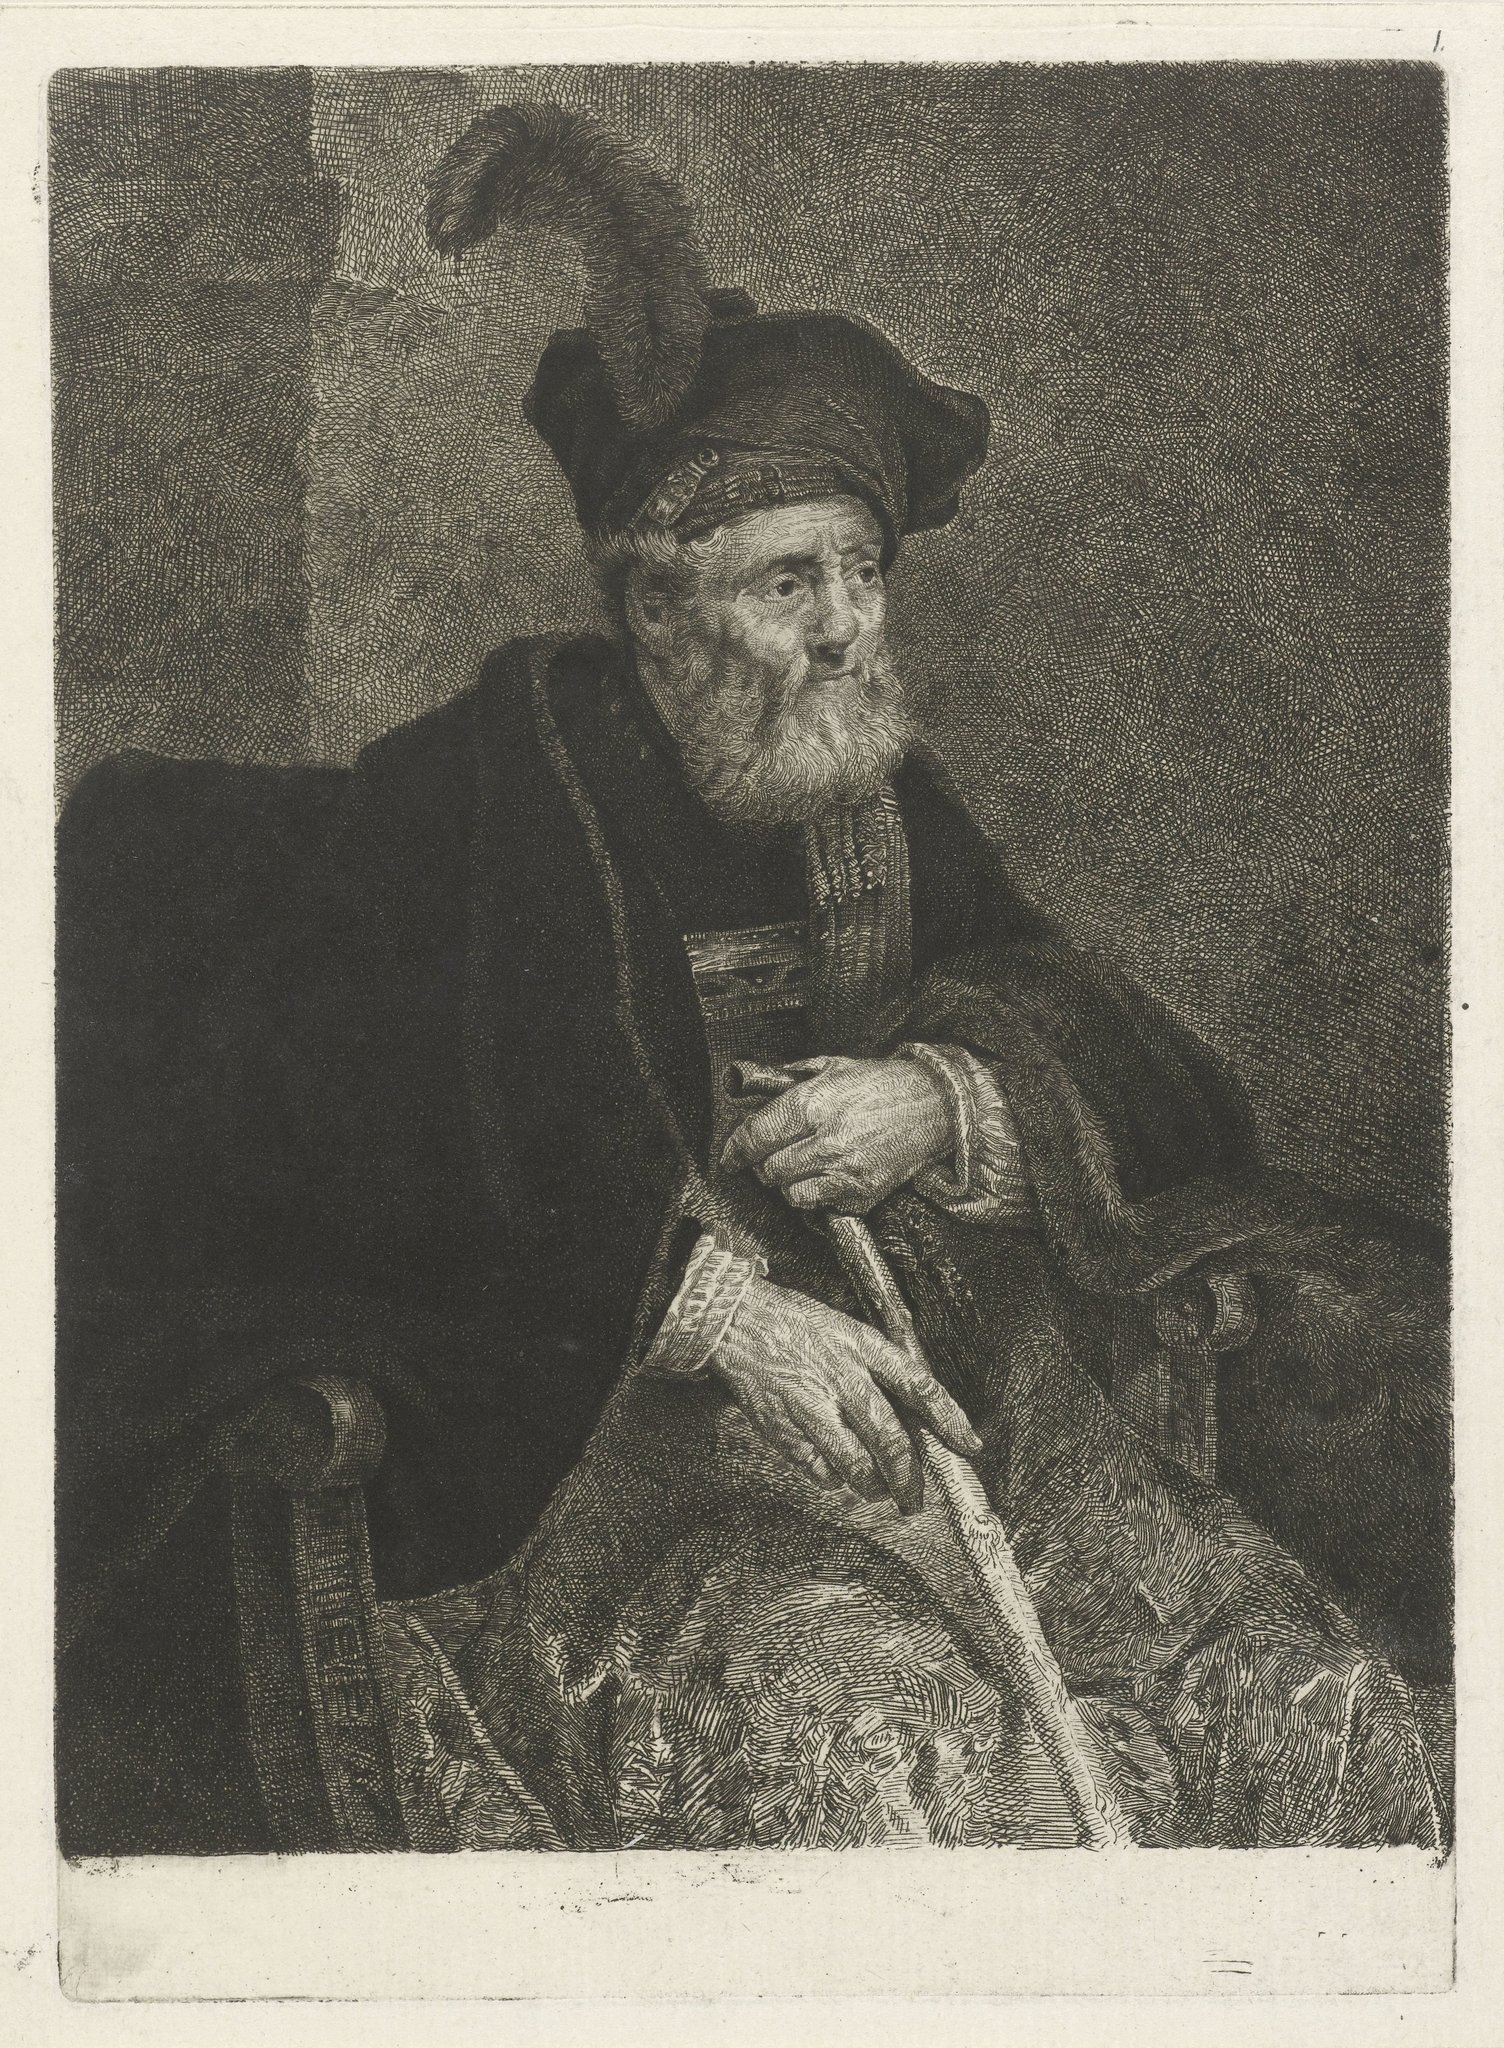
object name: print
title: Portret van een onbekende oude man in een stoel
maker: johannes pieter de frey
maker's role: draughtsman, print maker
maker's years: 1770-1834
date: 1797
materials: paper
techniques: etching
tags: sitting figure, head-gear (+ feathers used for clothes), old man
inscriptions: collector's mark: Lugt 12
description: Portret van een onbekende oude man in een stoel. Kniestuk, zittend naar rechts gedraaid. Zijn handen omklemmen een wandelstok. De man is gehuld in een met bont omzoomde mantel, zijn hoofd is getooid met een gevederde hoed.